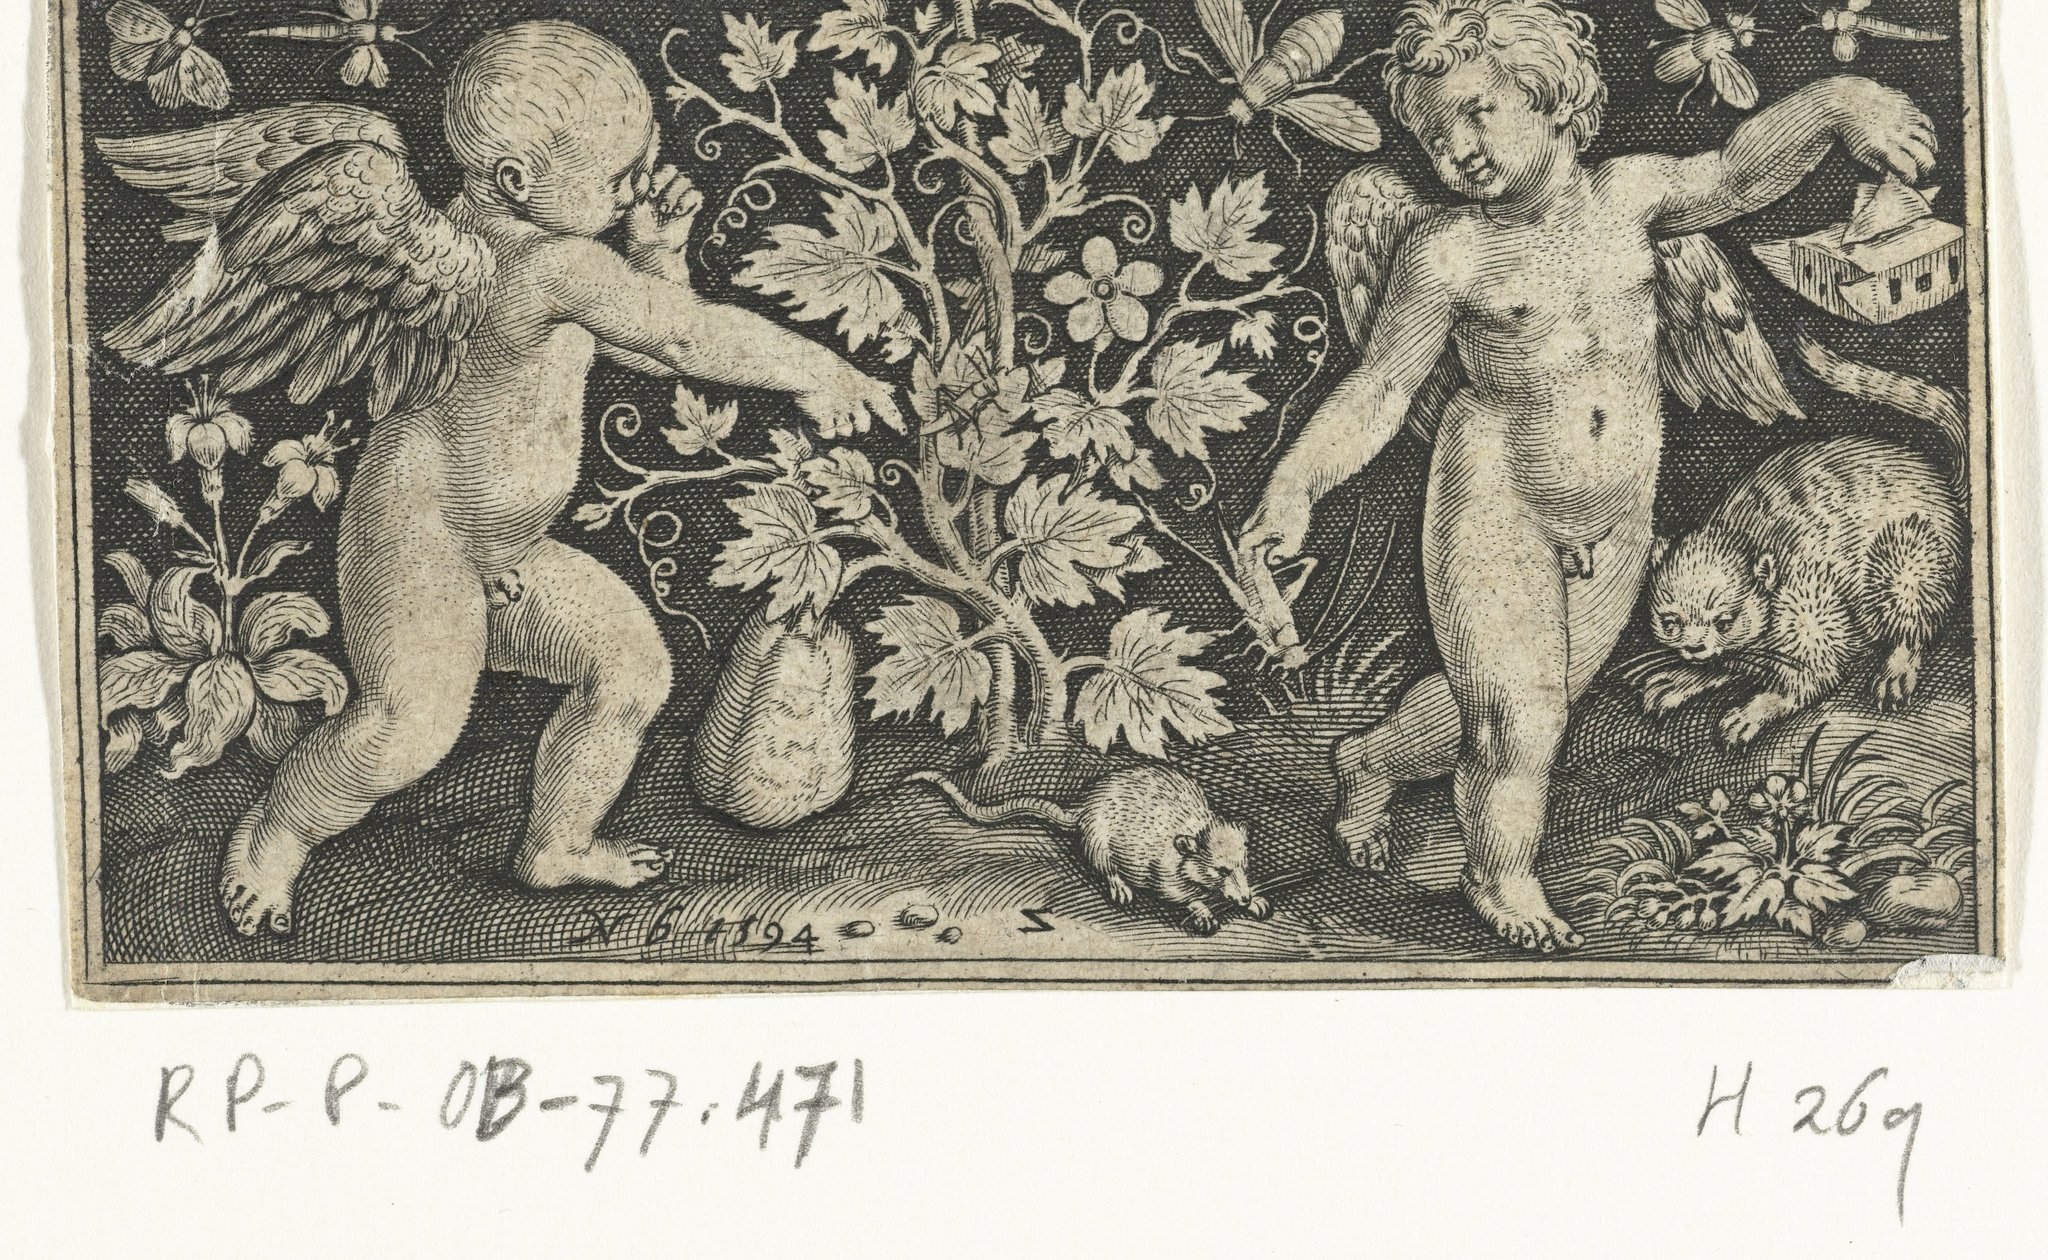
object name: print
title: Friezen met kinderen, engeltjes en dieren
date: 1594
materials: paper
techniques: engraving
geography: netherlands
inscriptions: collector's mark: Lugt 2228, collector's mark: Lugt 740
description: Prent uit serie van zes prenten met Friezen met kinderen, engeltjes en dieren. Hollstein beschrijft deze serie twee keer onder de nrs. 142-147 en 268-273.